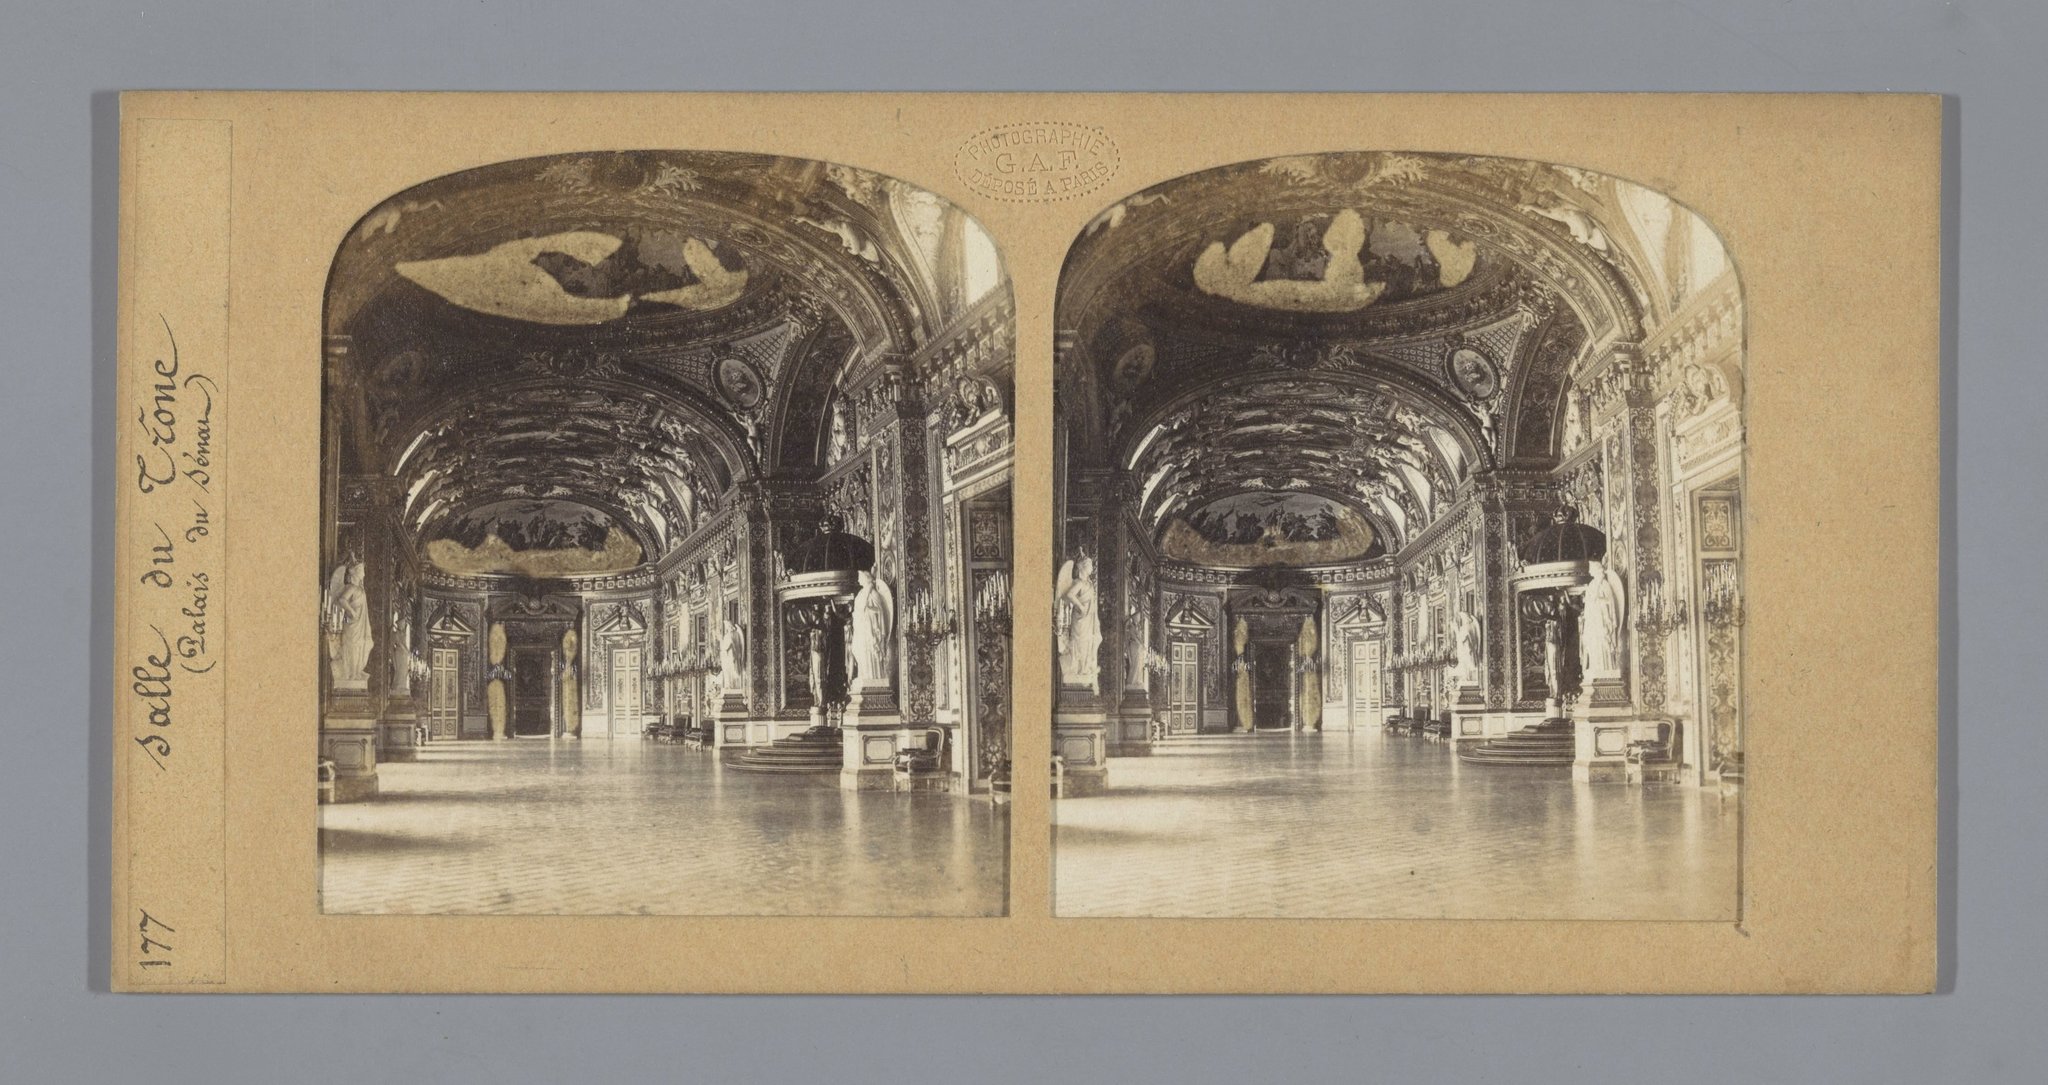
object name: tissue stereograph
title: Salle du Trône (Palais du Sénat)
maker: florent grau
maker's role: manufacturer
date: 1859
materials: cardboard, paper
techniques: albumen print, hand coloring, perforating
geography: paris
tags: throne-room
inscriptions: number: ‘177’, inscription: ‘Déposé a Paris’